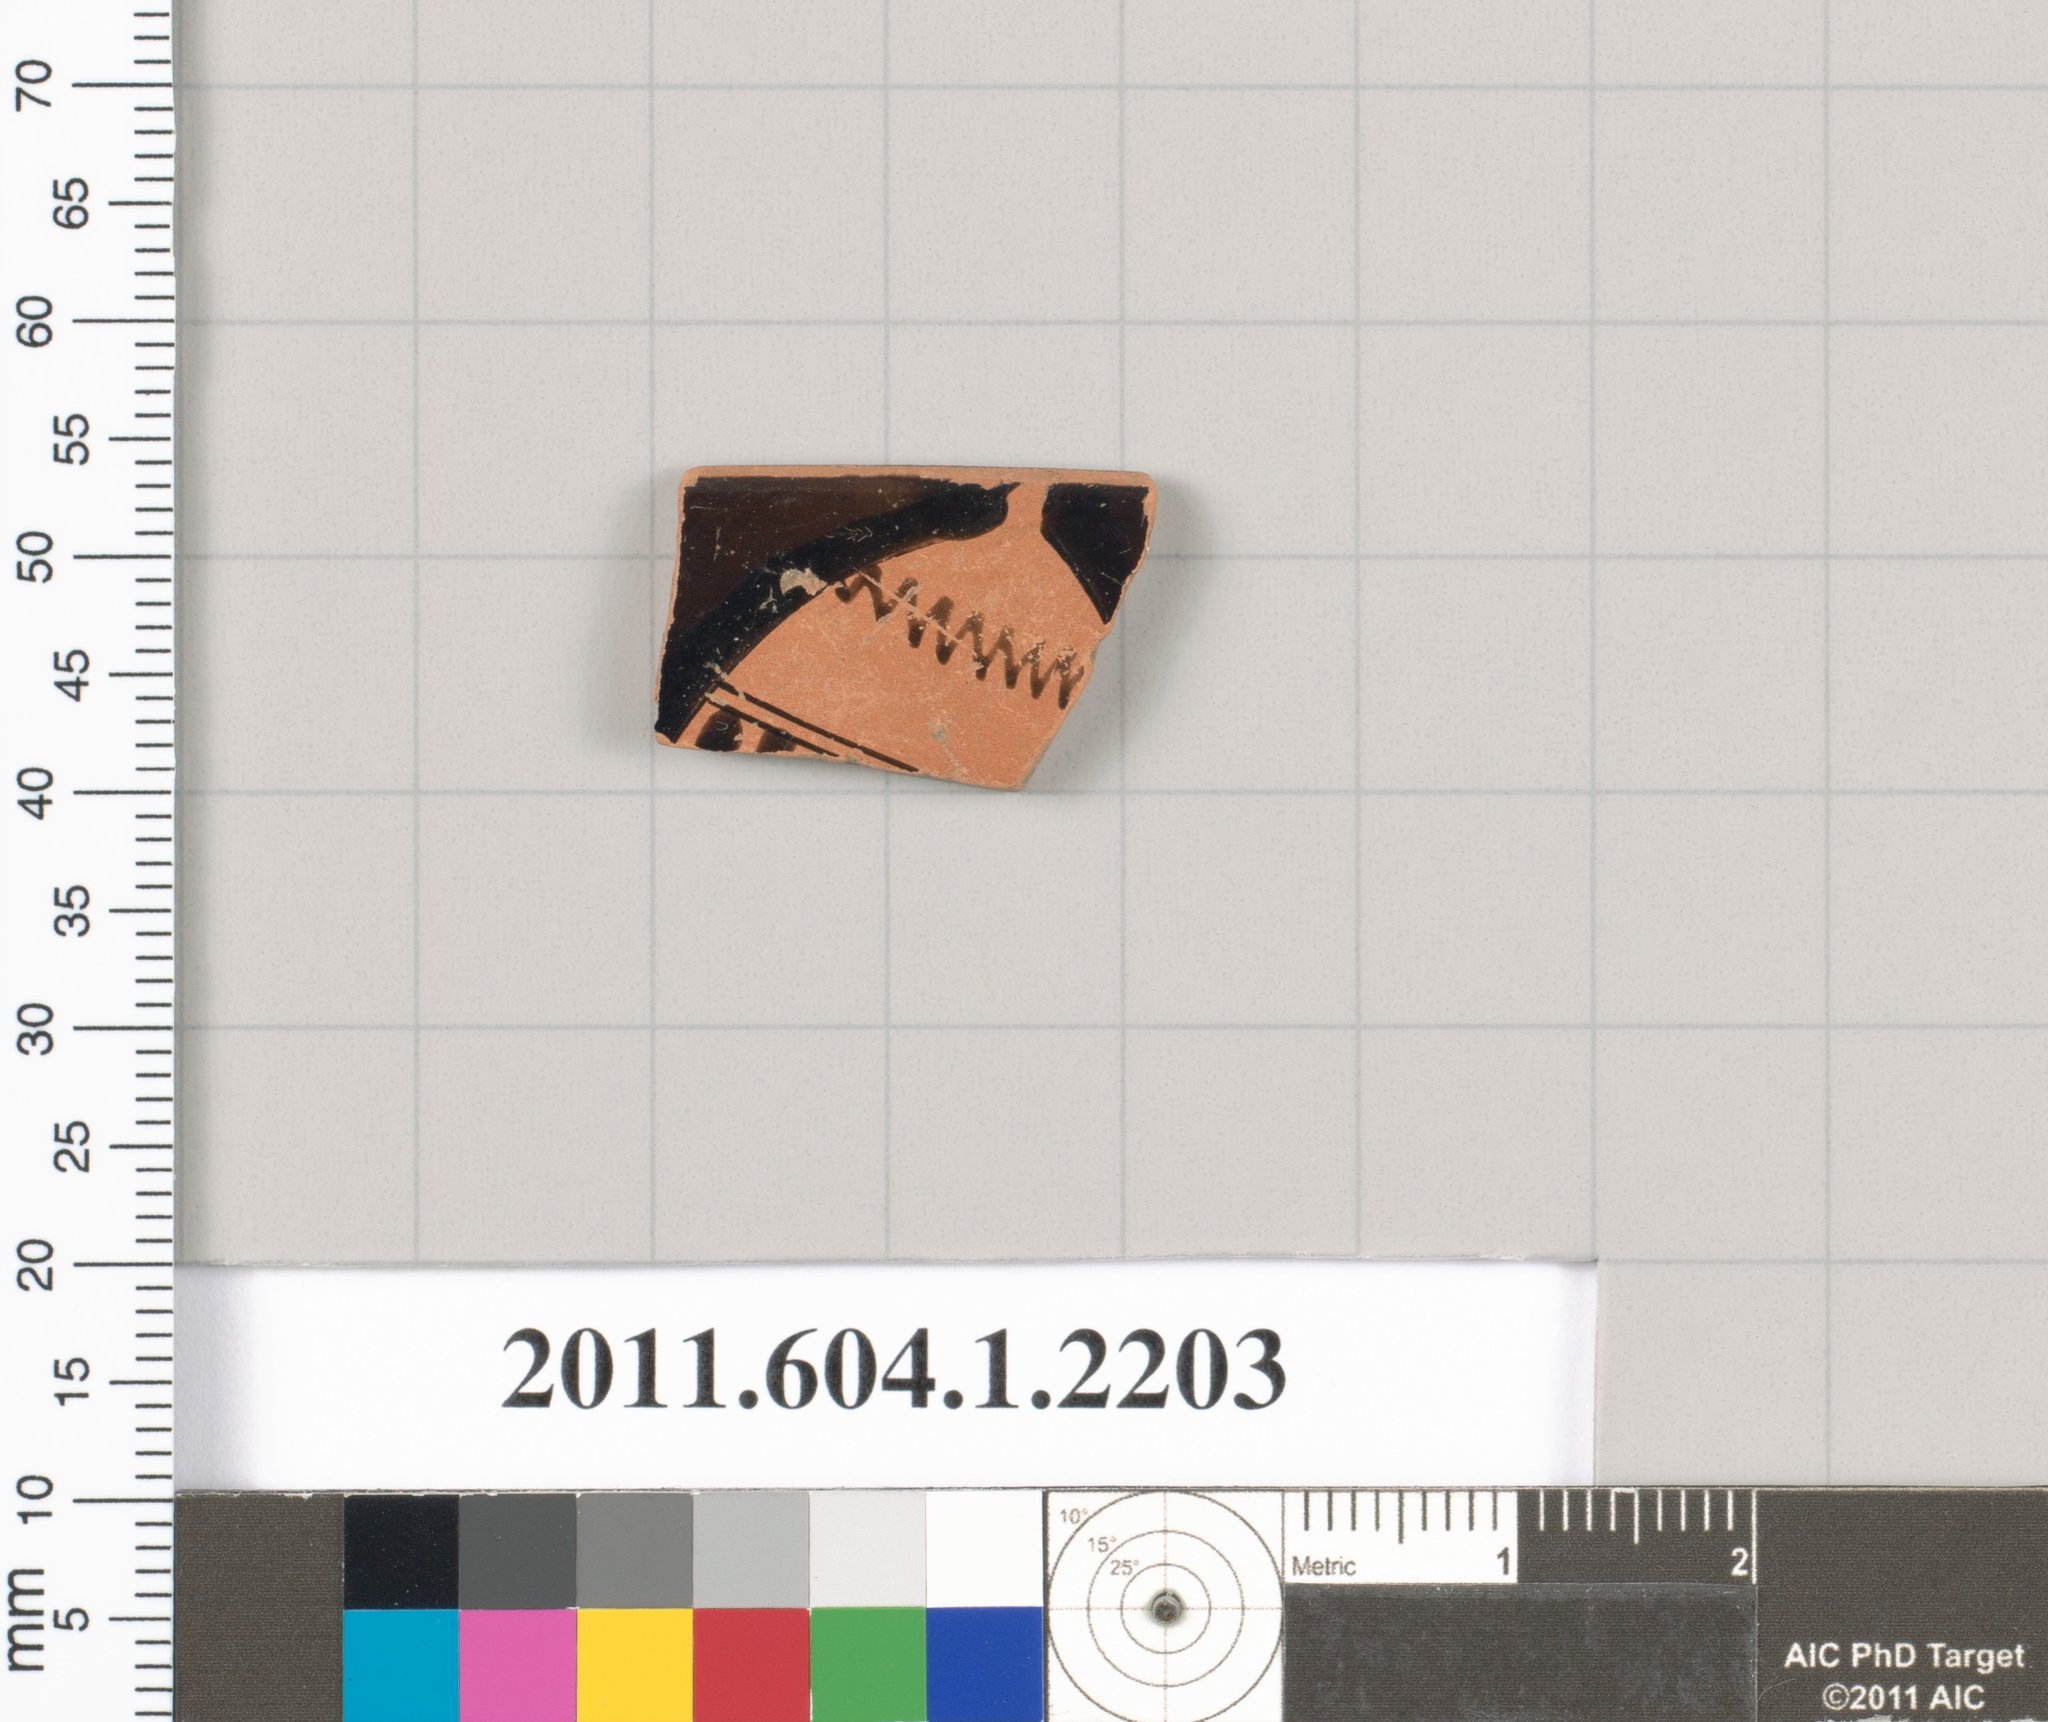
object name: kylix fragment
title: Terracotta rim fragment of a kylix (drinking cup)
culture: greek, attic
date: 500-476 BCE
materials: terracotta